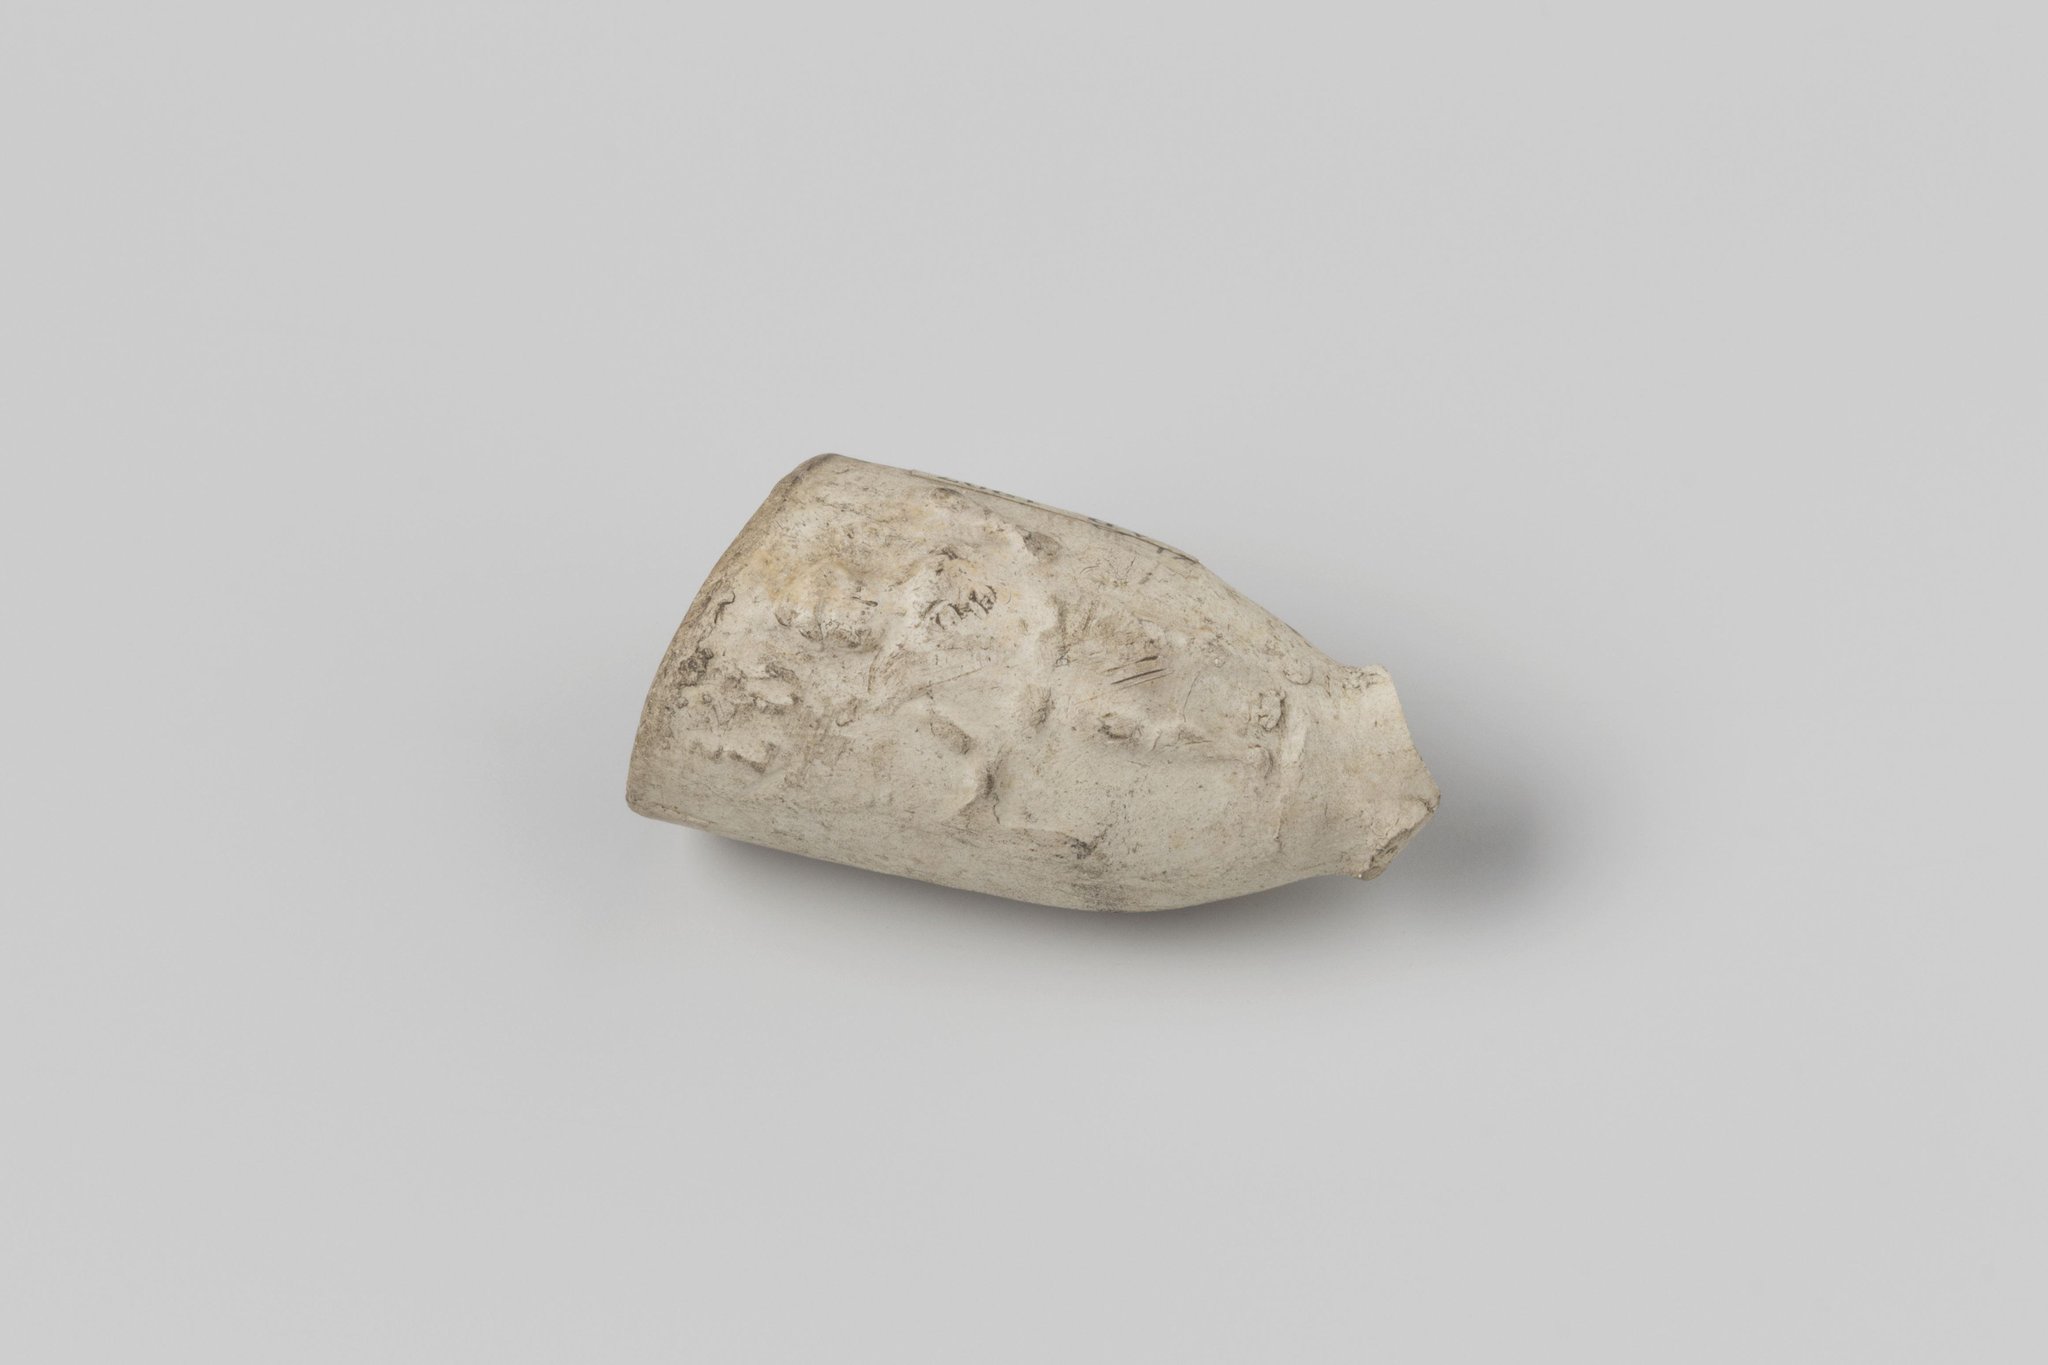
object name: fragment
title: Pijpenkop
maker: Anonymous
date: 1700-1799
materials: clay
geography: netherlands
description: Pijpenkop met aan de ene zijde een wapen met twee sleutels en aan de andere zijde een figuur afgebeeld. Van de opgravingen op de Hofstede Arentsburg 1827-1831 onder toezicht van Professor Reuvens.